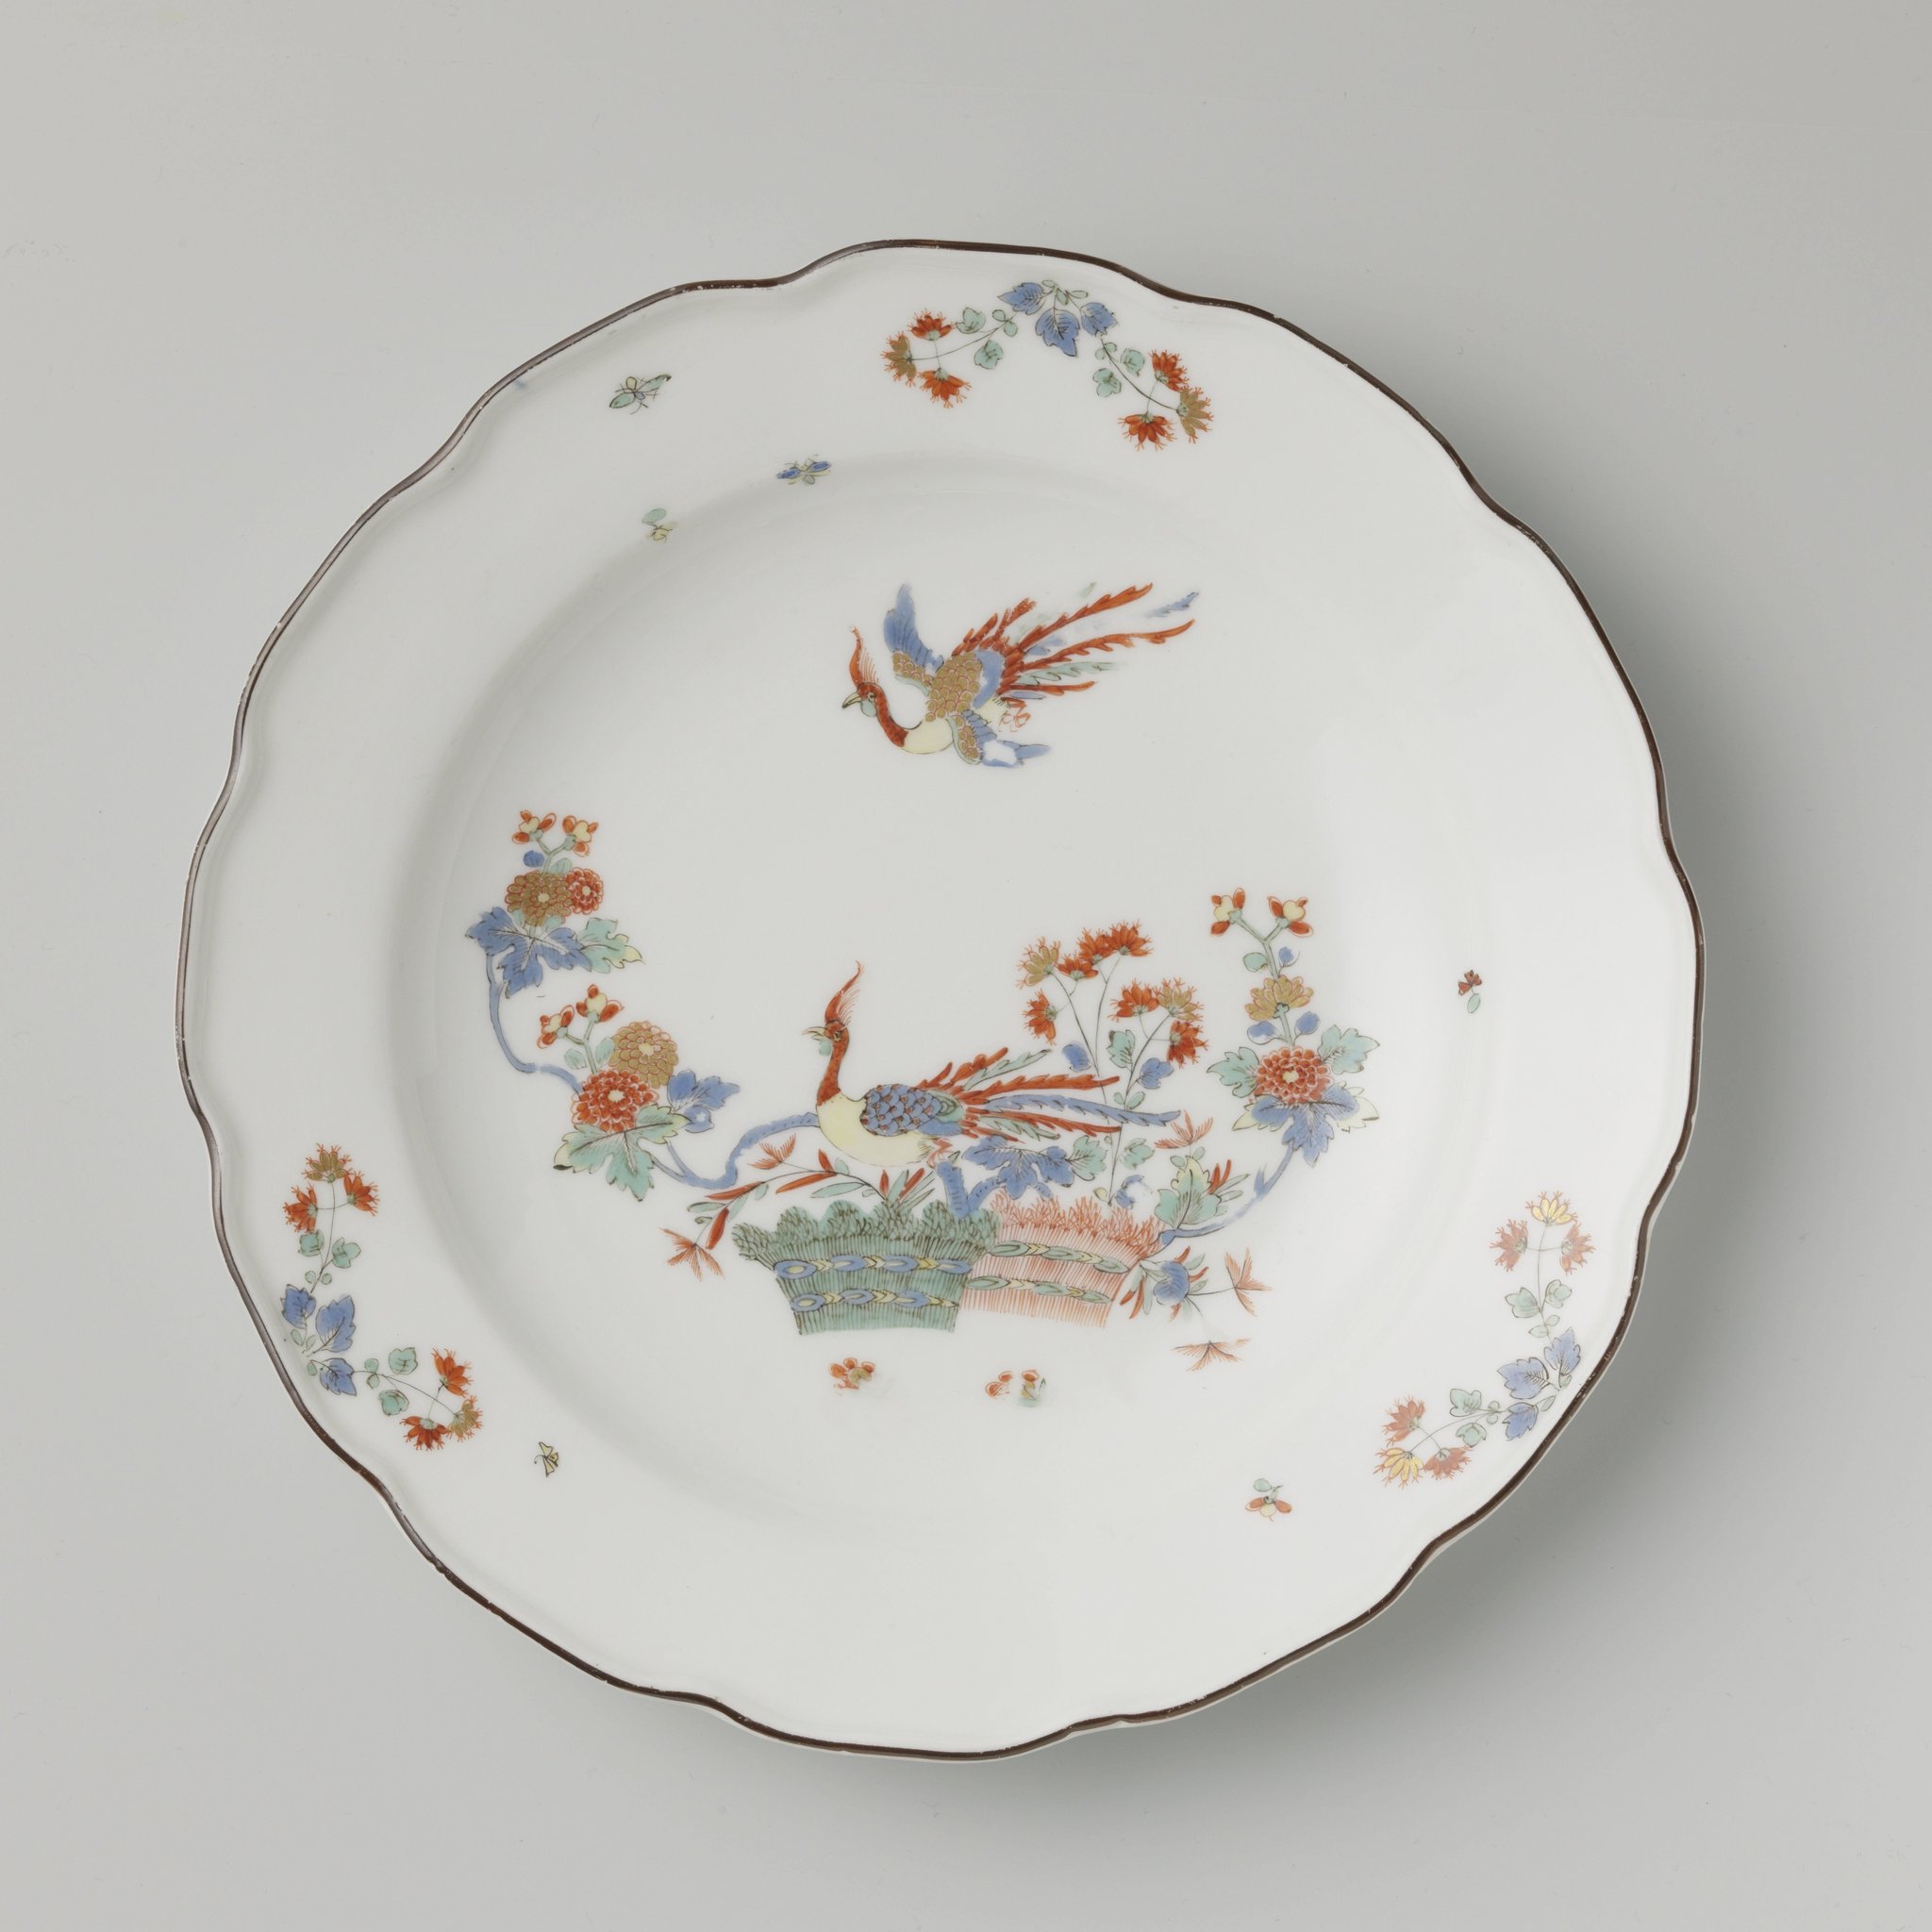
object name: eating drinking utensil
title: Bord, veelkleurig beschilderd met een Kakiemon-decor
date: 1740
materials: porcelain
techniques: painted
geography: meissen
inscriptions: mold mark: ‘16’, factory mark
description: Plate. Meissen, c. 1740 - 1750. Sauceboat. Meissen, c. 1730 - 1735.